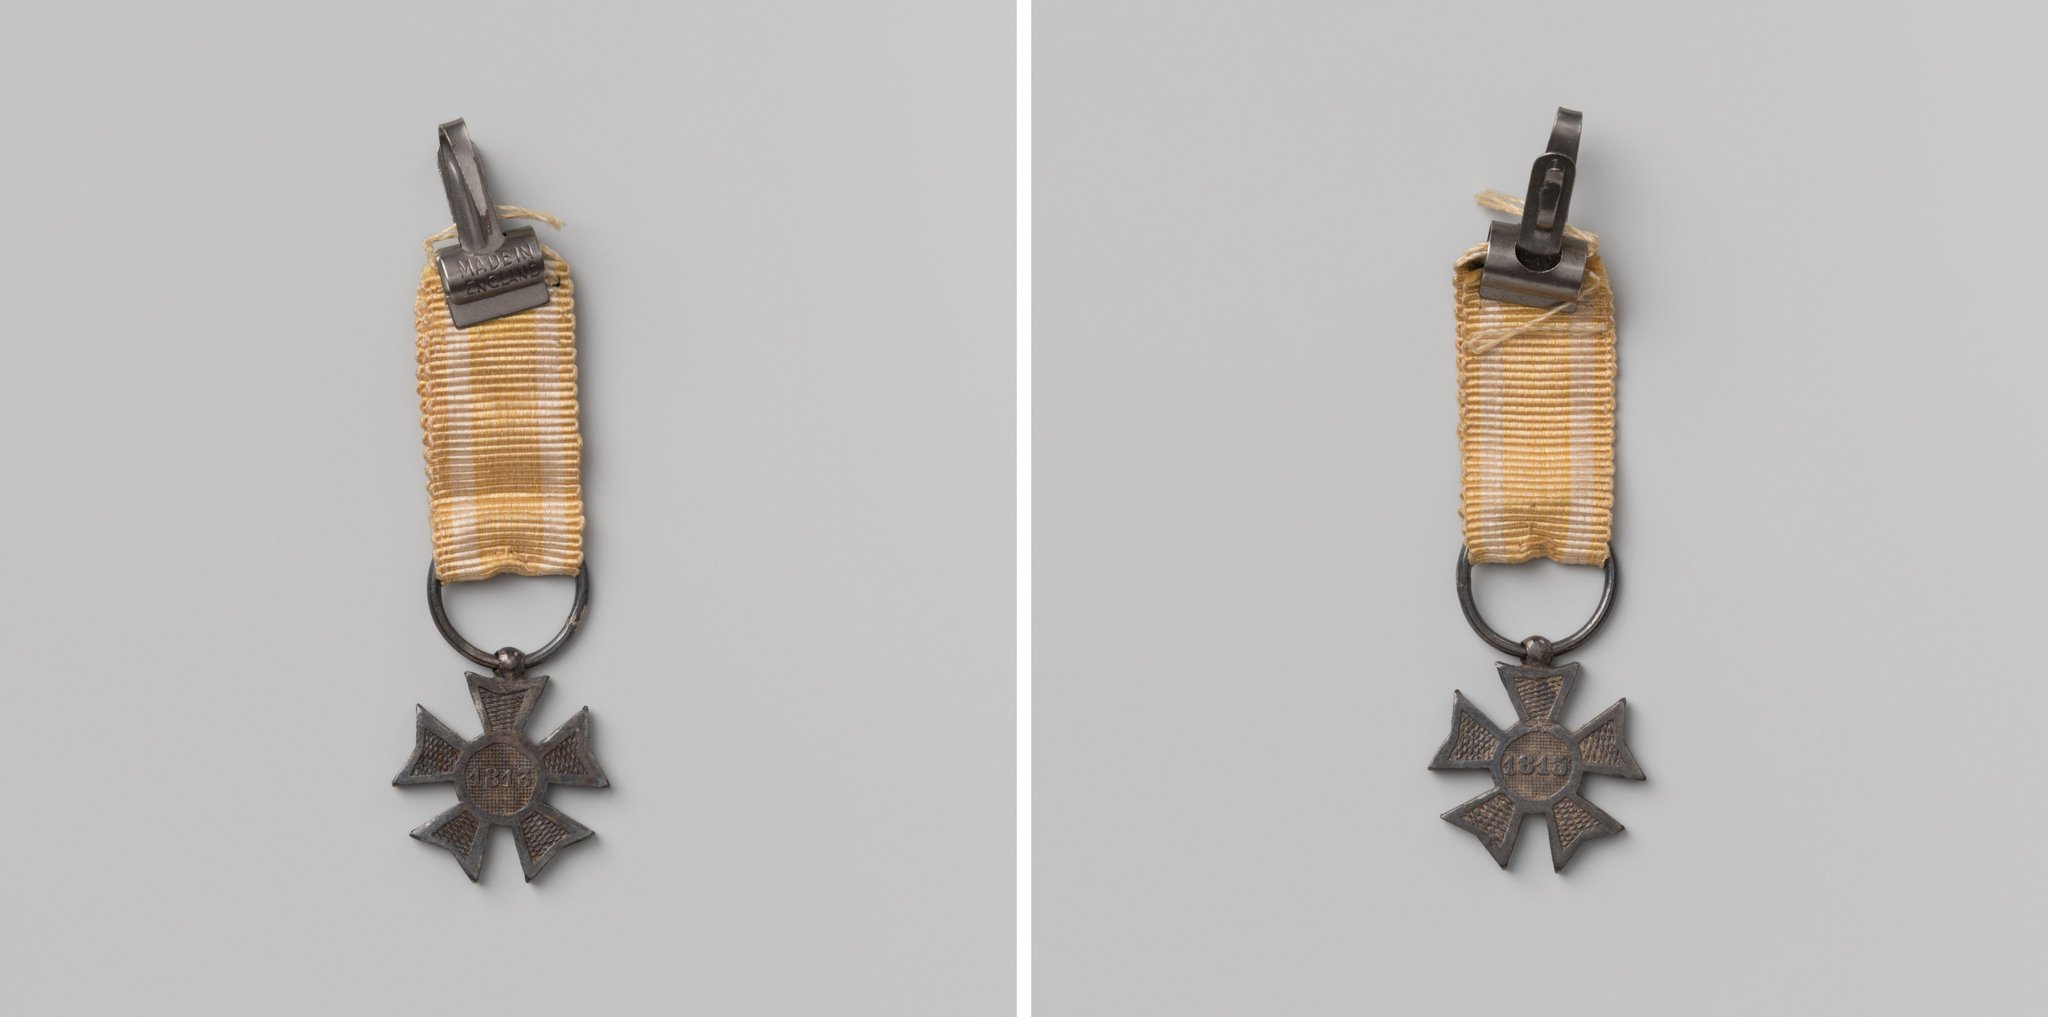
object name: insignia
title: Zilveren Herinnerings Kruis 1813-1815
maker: Anonymous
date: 1863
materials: silver, textile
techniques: soldering, striking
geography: england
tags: napoleontische oorlogen